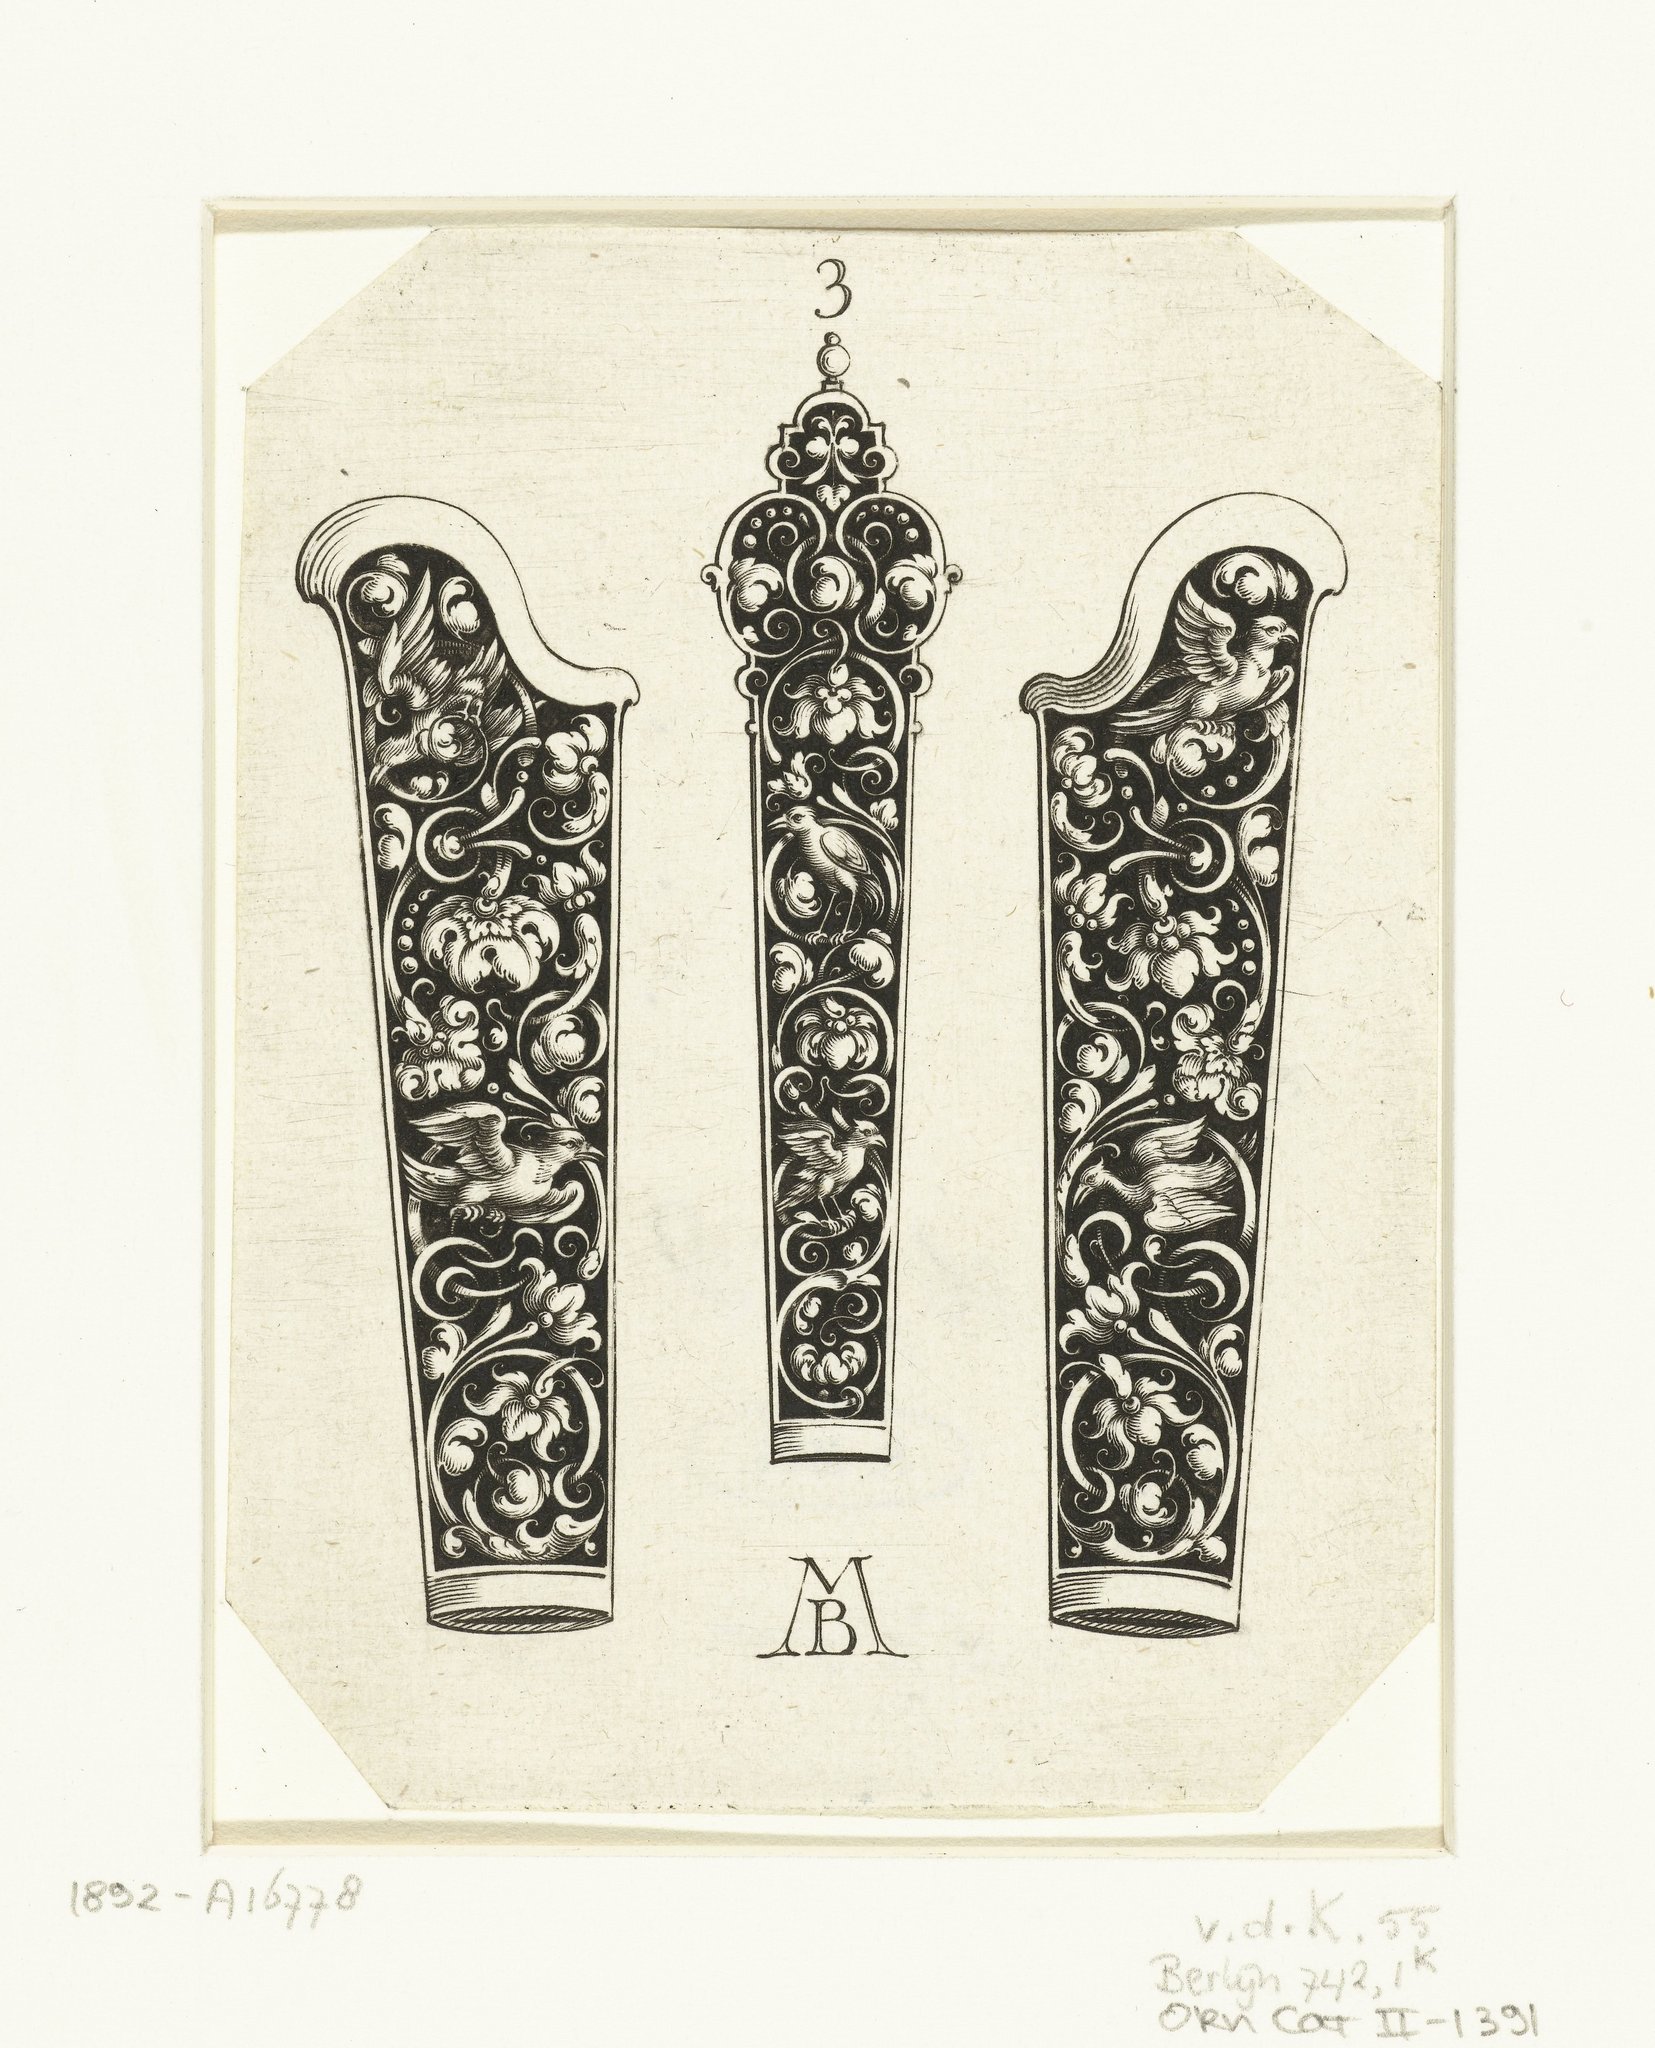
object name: ornament print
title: Drie messenheften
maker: michiel le blon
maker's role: print maker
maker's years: 1587-1656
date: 1626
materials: paper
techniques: etching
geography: amsterdam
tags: foliage ~ ornament, birds, table-knife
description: Het middelste heft is bekroond met een knop.